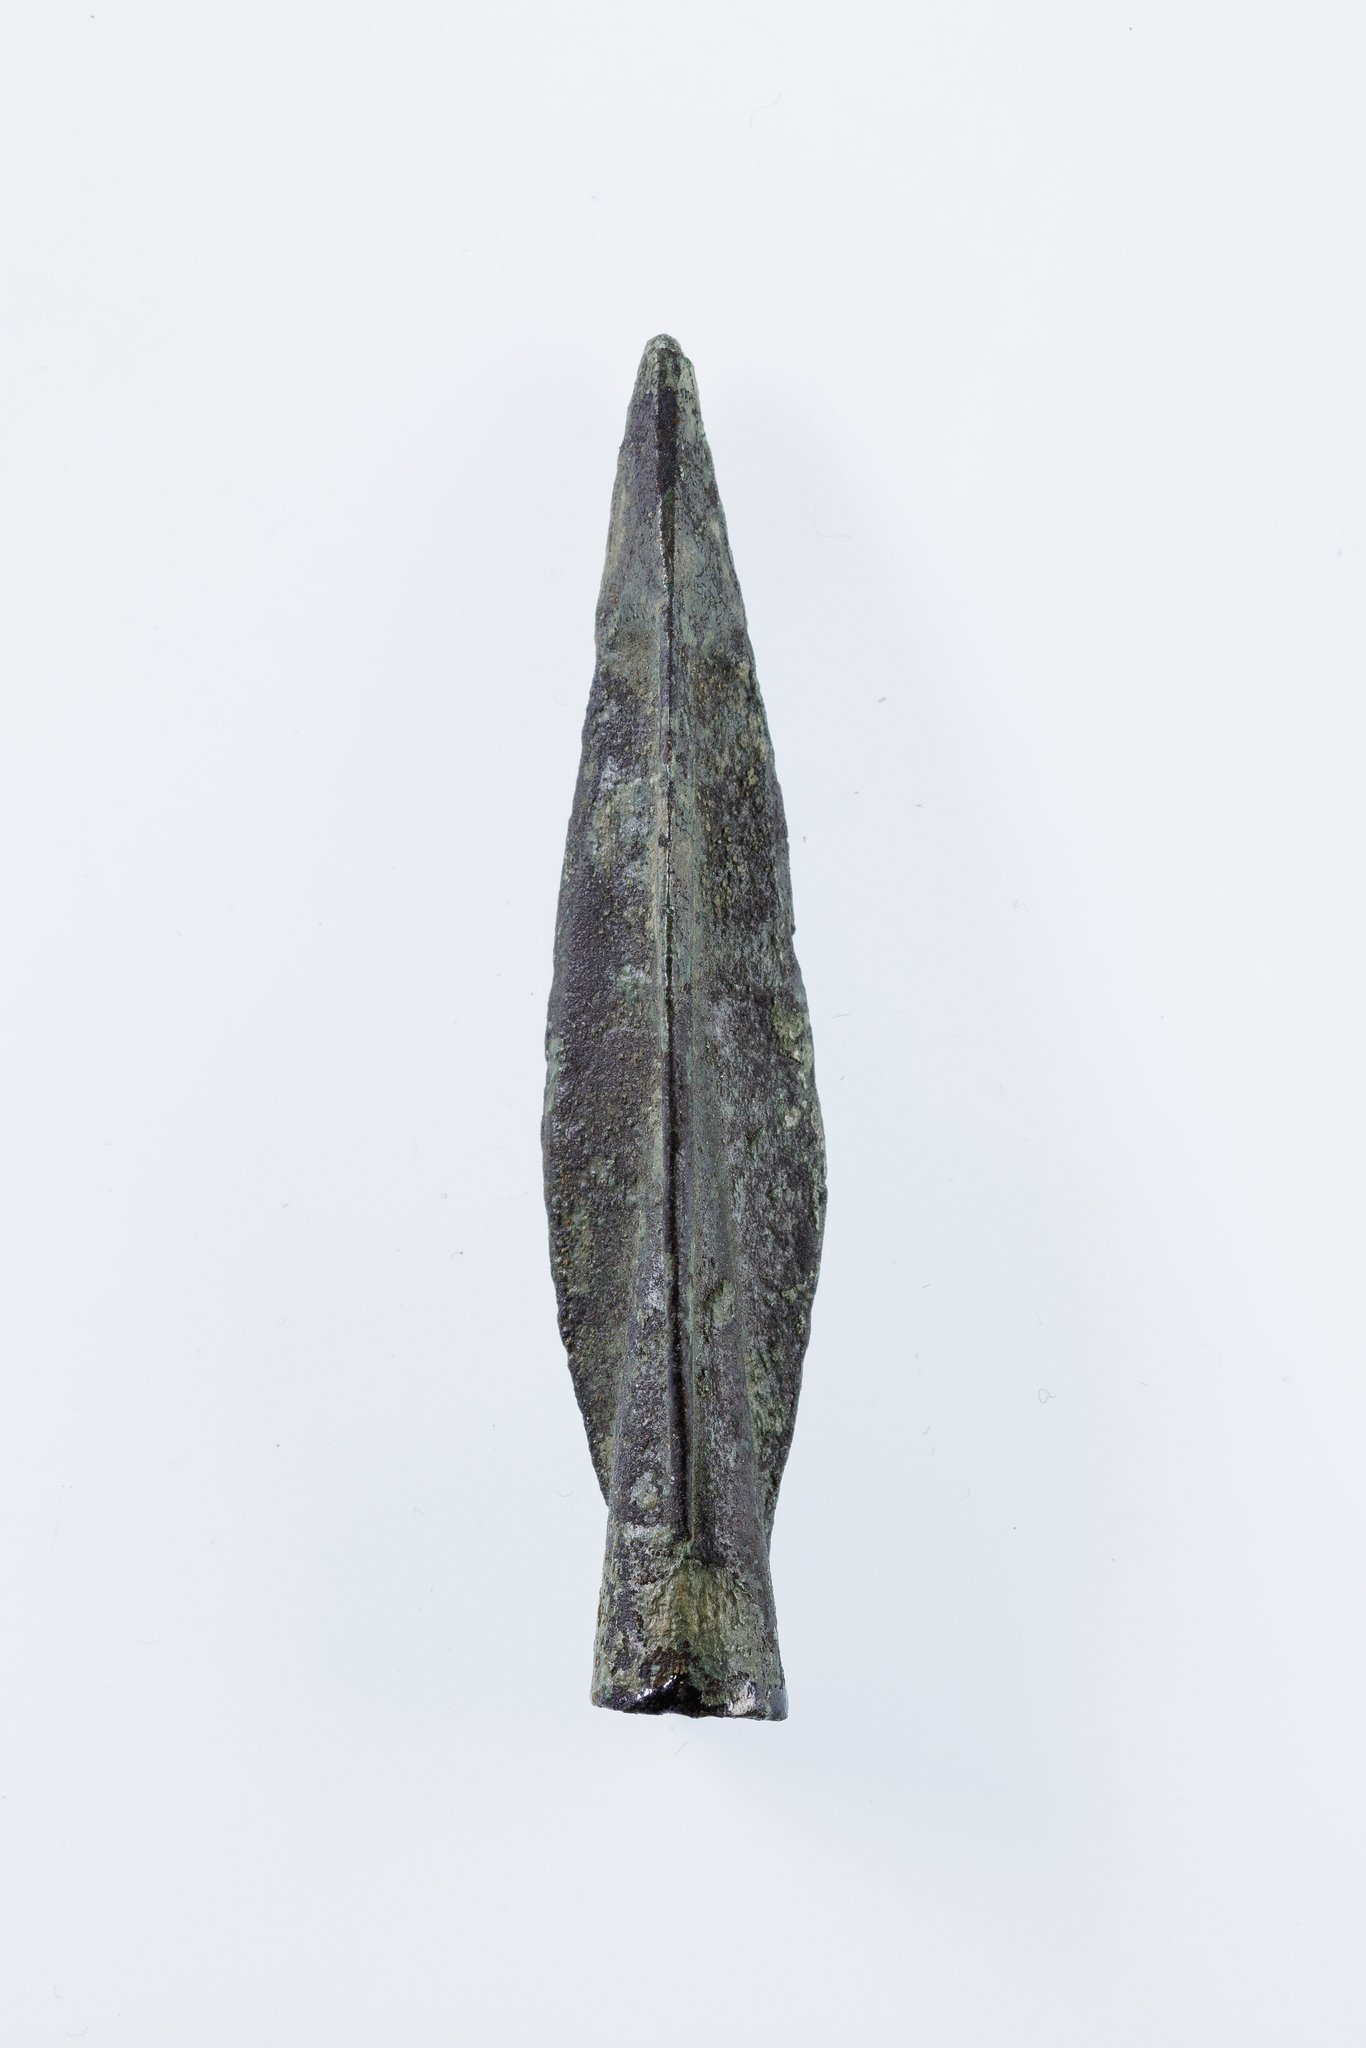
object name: arrow point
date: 664-525 BCE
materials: bronze, copper alloy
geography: egypt